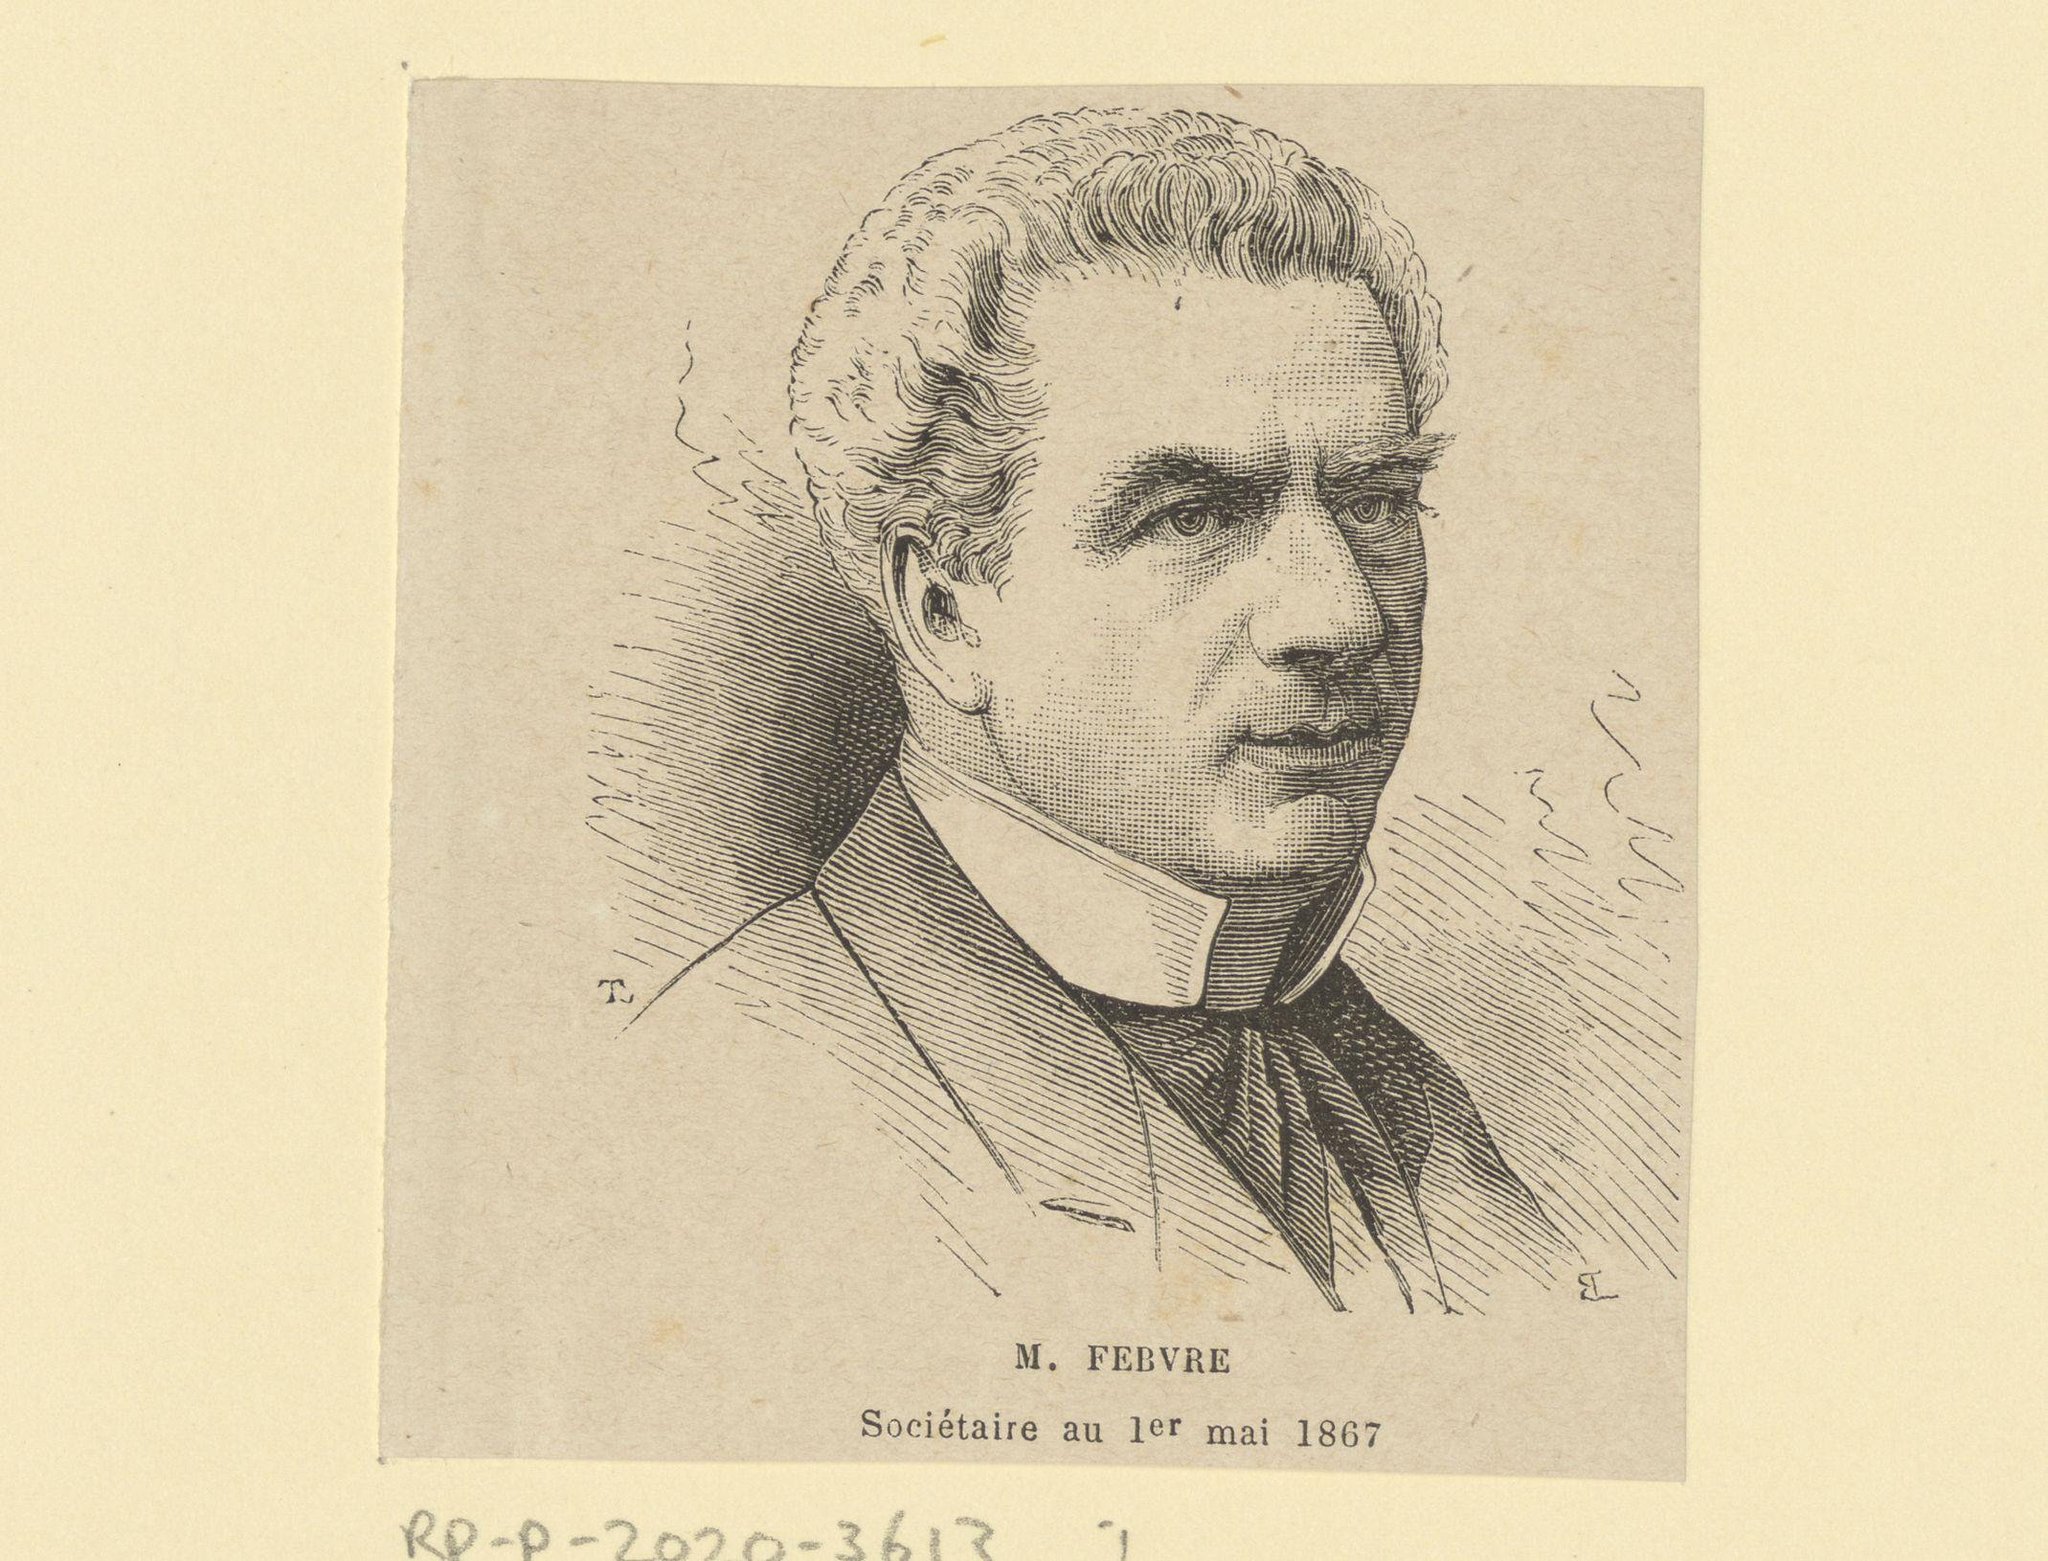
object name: print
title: Portret van Frédéric Febvre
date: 1879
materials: paper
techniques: letterpress printing, engraving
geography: paris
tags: historical persons, portrait of actor, actress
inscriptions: monogram: ‘T.’, monogram: ‘B.’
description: Prent uit: Le Monde Illustré 23 (1879), nr. 1163, 16 augustus 1879.